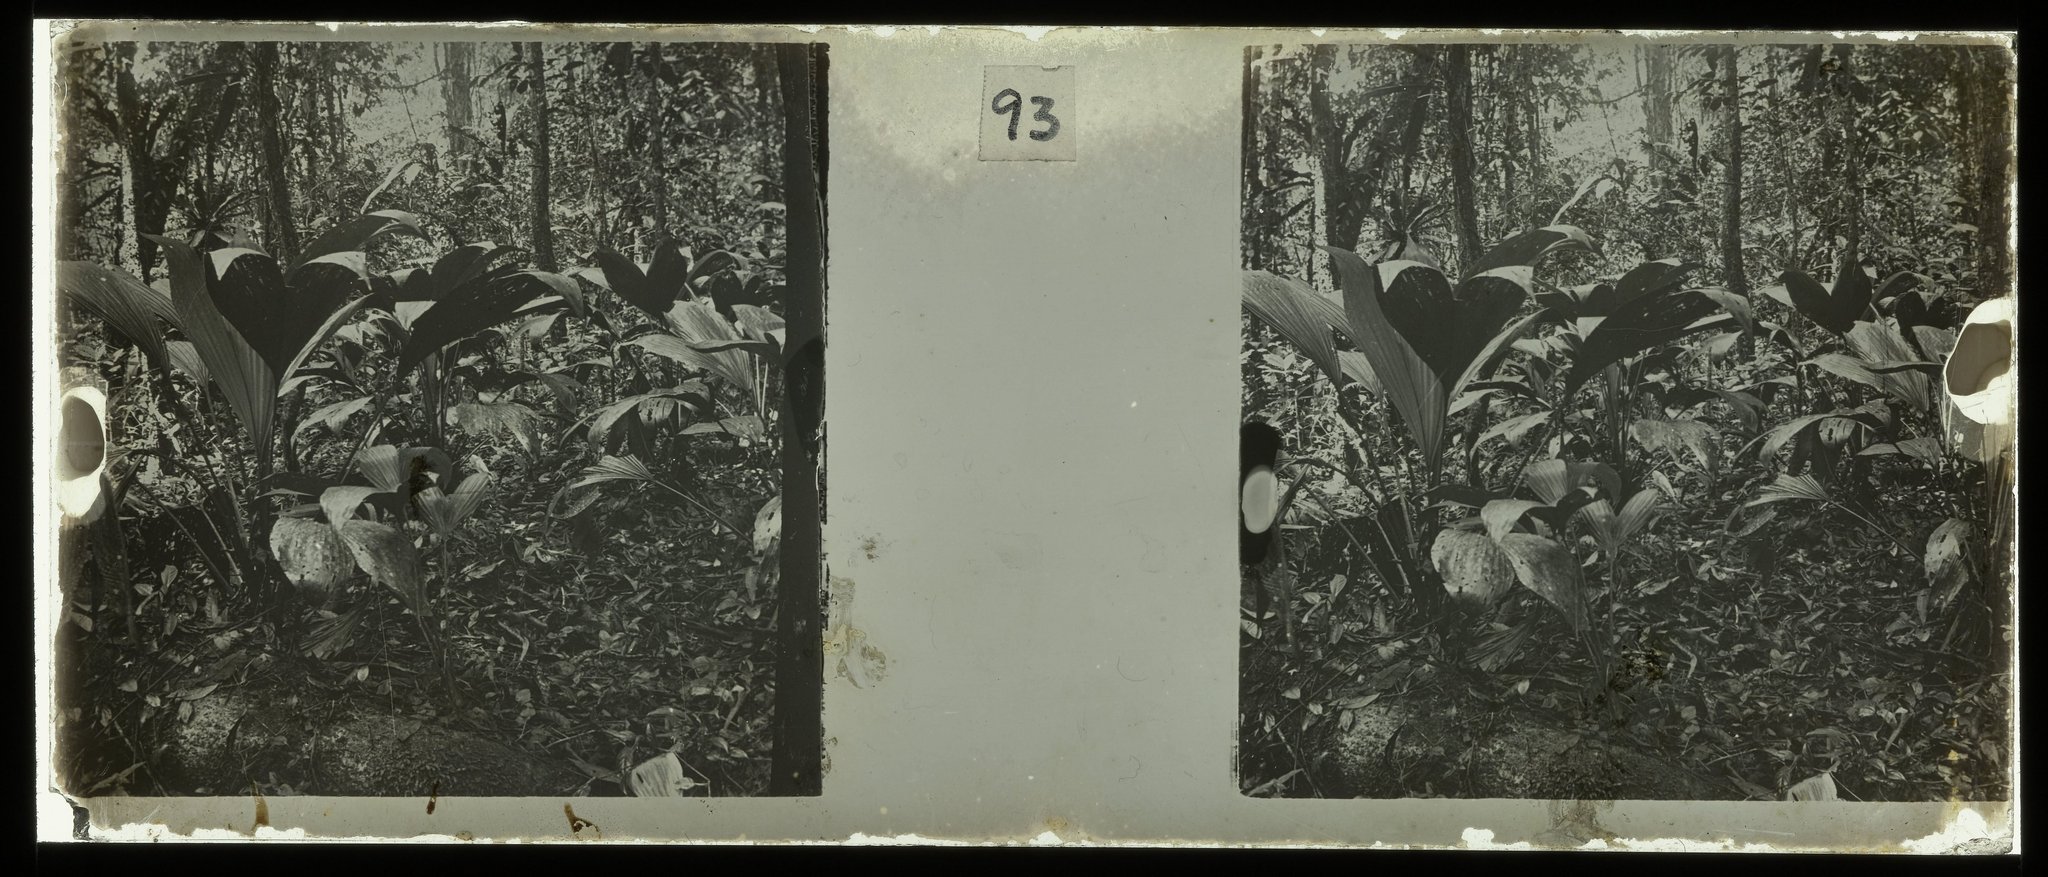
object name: stereograph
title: Plantage Accaribo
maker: theodoor brouwers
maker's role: amateurfotograaf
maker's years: 1874-1932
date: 1913-1930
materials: glass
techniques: photography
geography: suriname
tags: amsterdam, theodoor brouwers, plantation, suriname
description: In de periode 1911-1932 woonde op plantage Accaribo in Suriname de familie Brouwers van wie de foto's afkomstig zijn. Rond 1910 vond Theodoor Brouwers werk op plantage Accaribo. In 1929 werd hij eigenaar van de plantage. Op Accaribo werden in zijn tijd bananen geproduceerd en wat koffie.